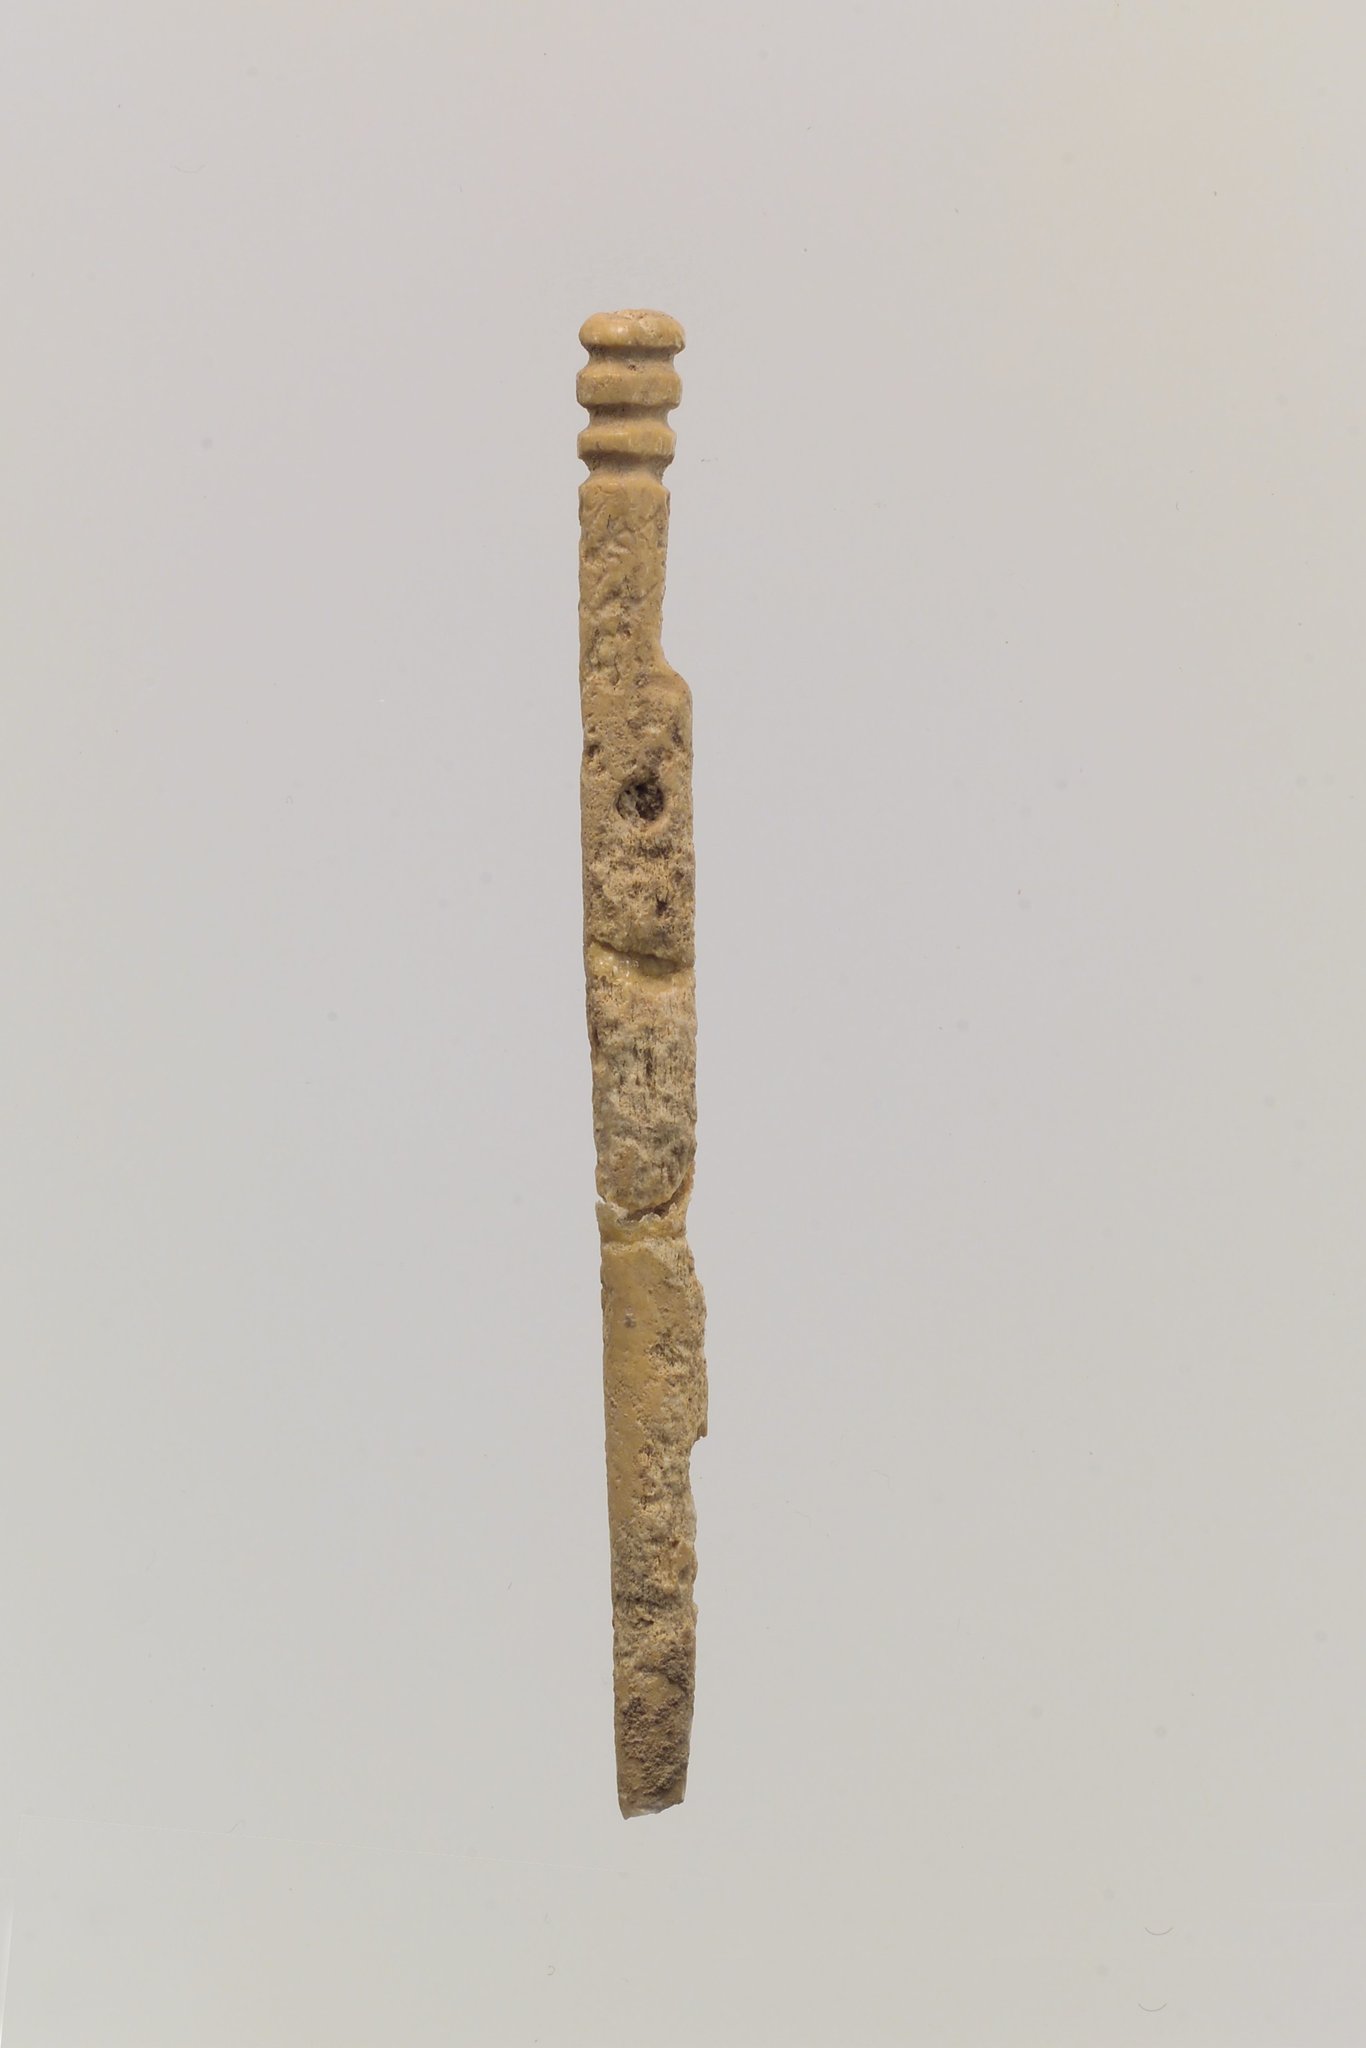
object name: pin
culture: sasanian or islamic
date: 501-800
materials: ivory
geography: iran